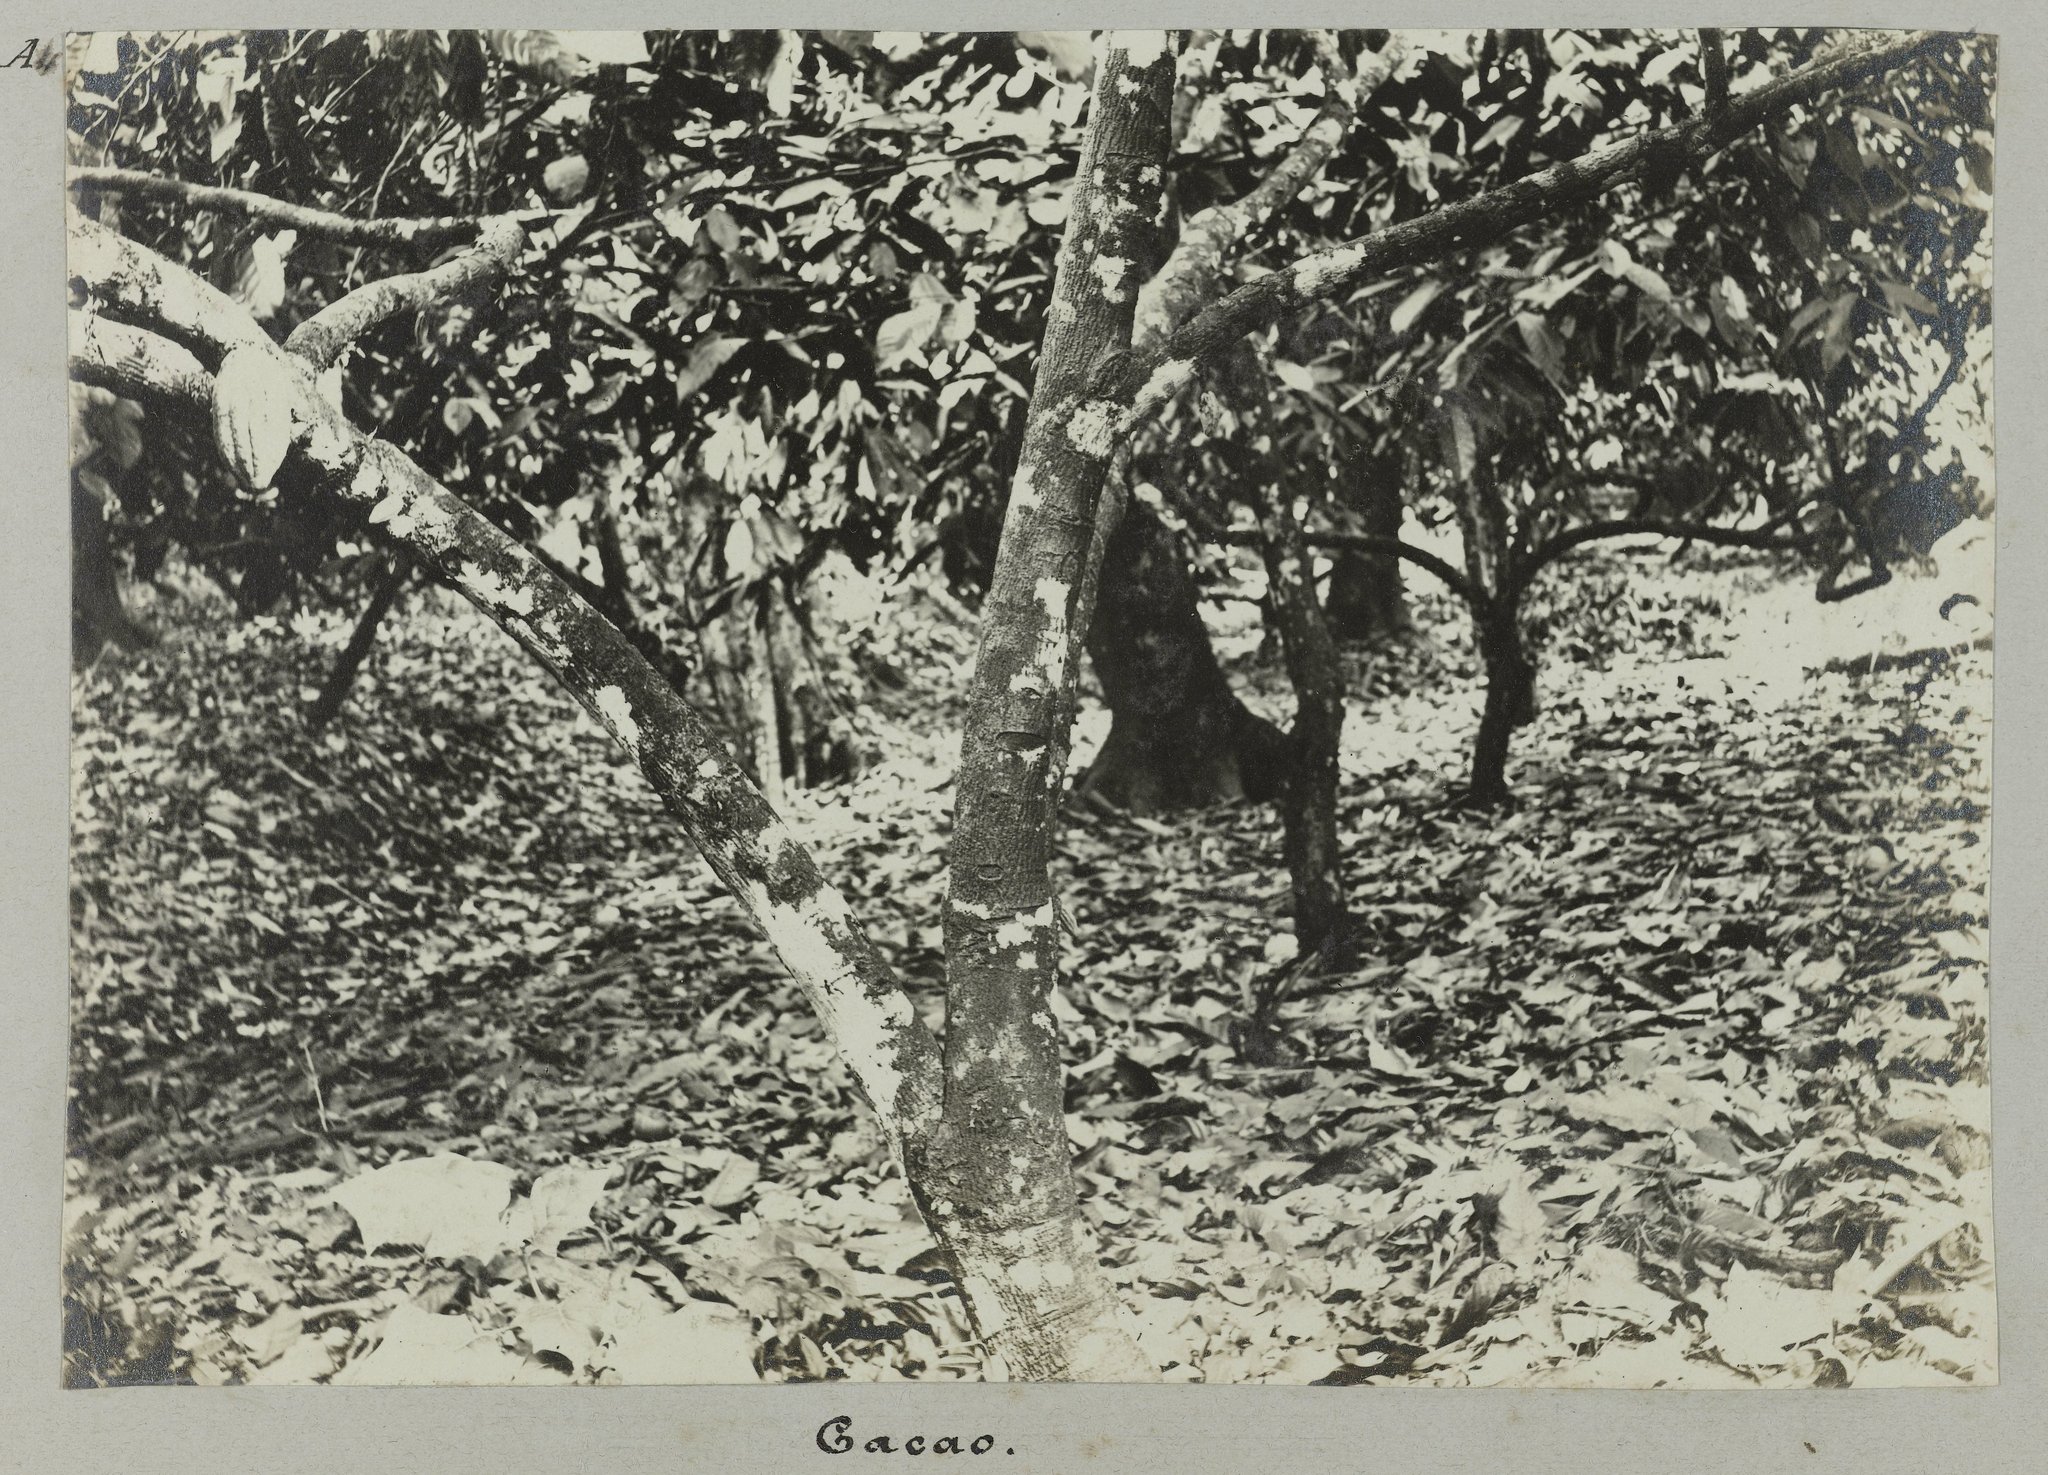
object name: photograph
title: Cacao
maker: hendrik doijer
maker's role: engineer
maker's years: 1863-1925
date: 1903-1910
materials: photographic support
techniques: gelatin silver print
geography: suriname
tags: suriname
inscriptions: inscription: ‘Cacao.’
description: Cacaobomen met vruchten groeiend op de plantage Tourtonne. Onderdeel van het fotoalbum Souvenir de Voyage (deel 1), over het leven van de familie Doijer in en rond de plantage Ma Retraite in Suriname in de jaren 1903-1910.